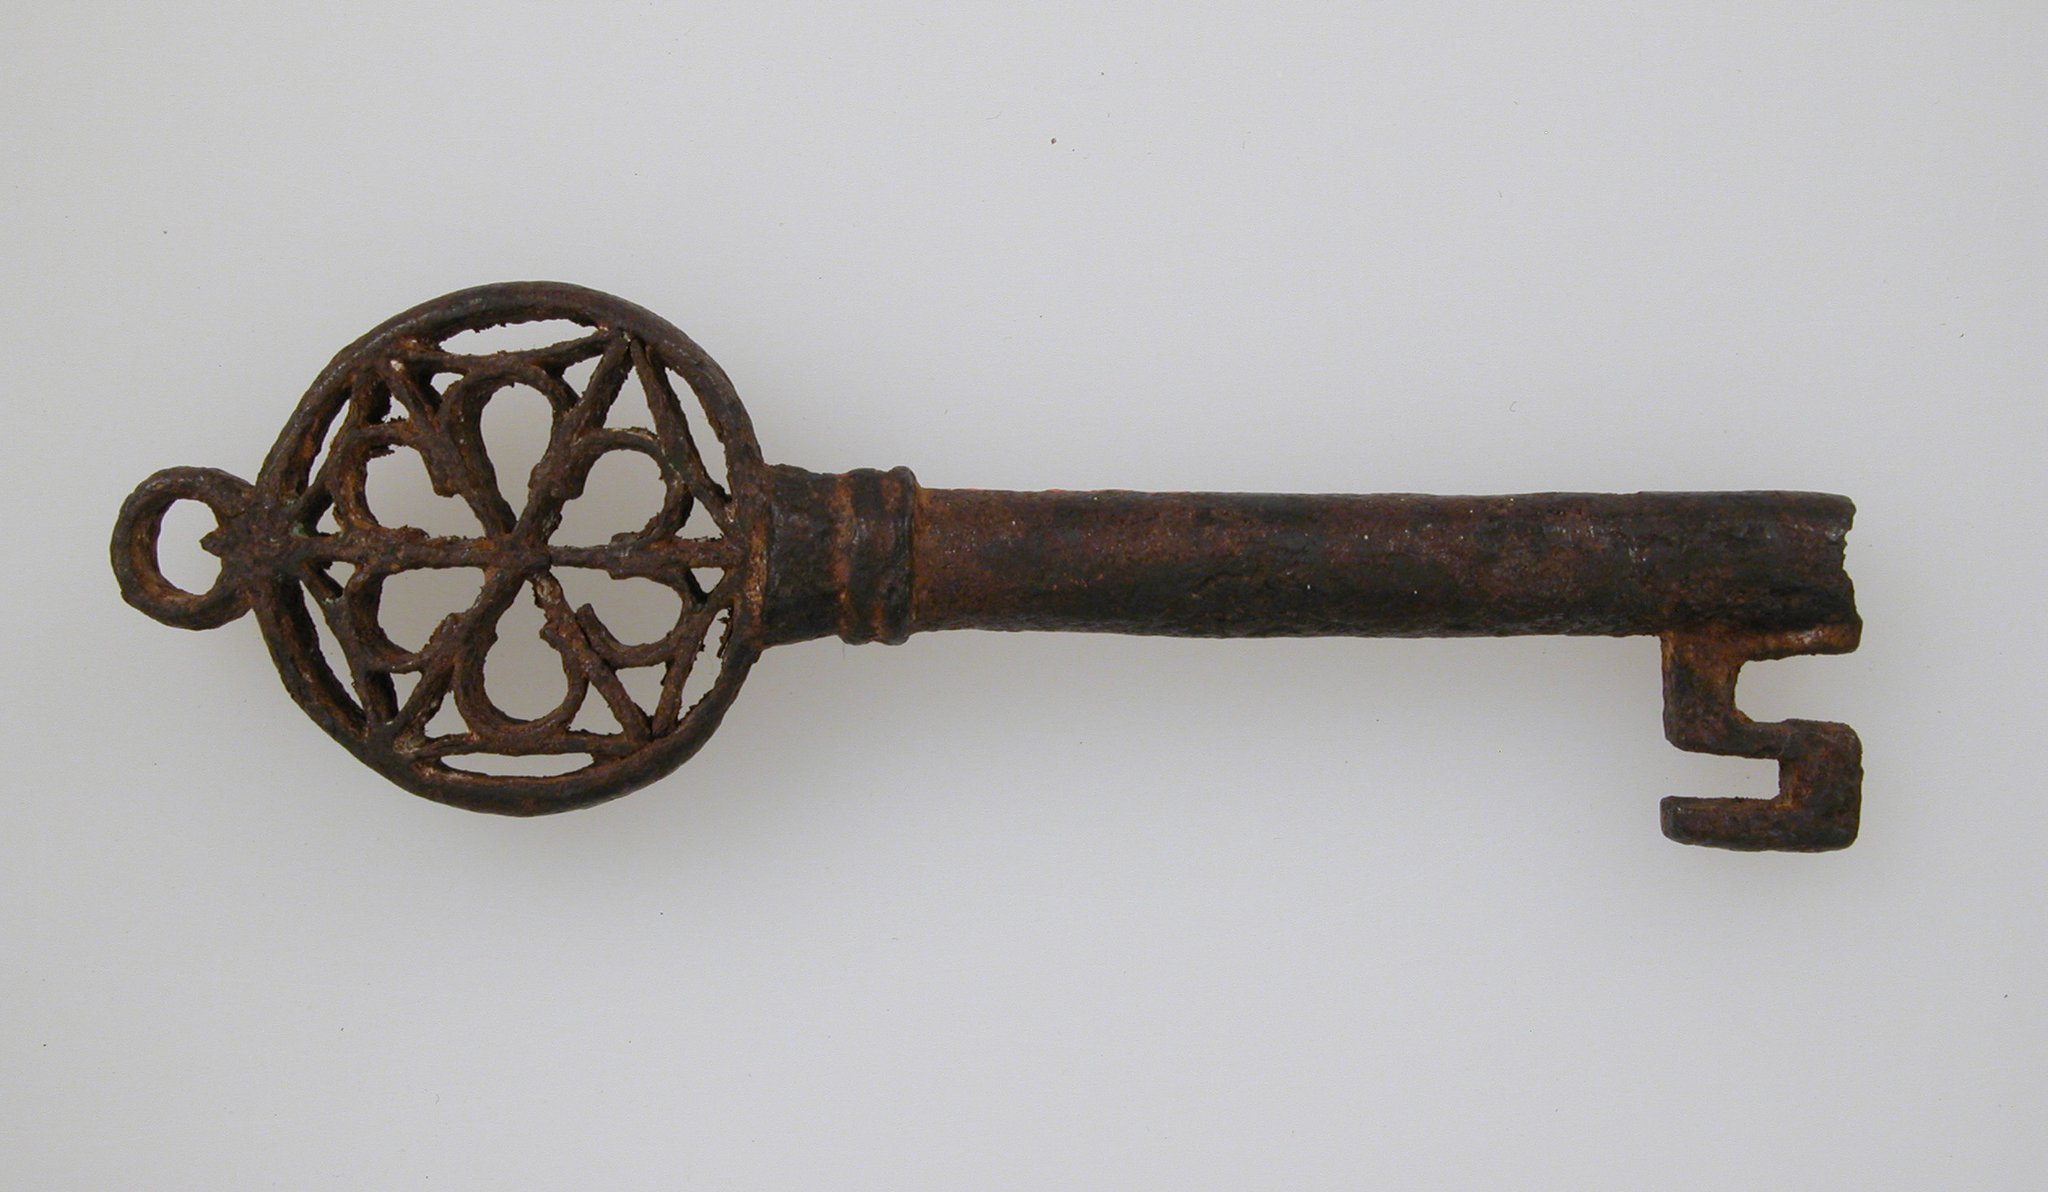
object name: key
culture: german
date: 1401-1500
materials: iron